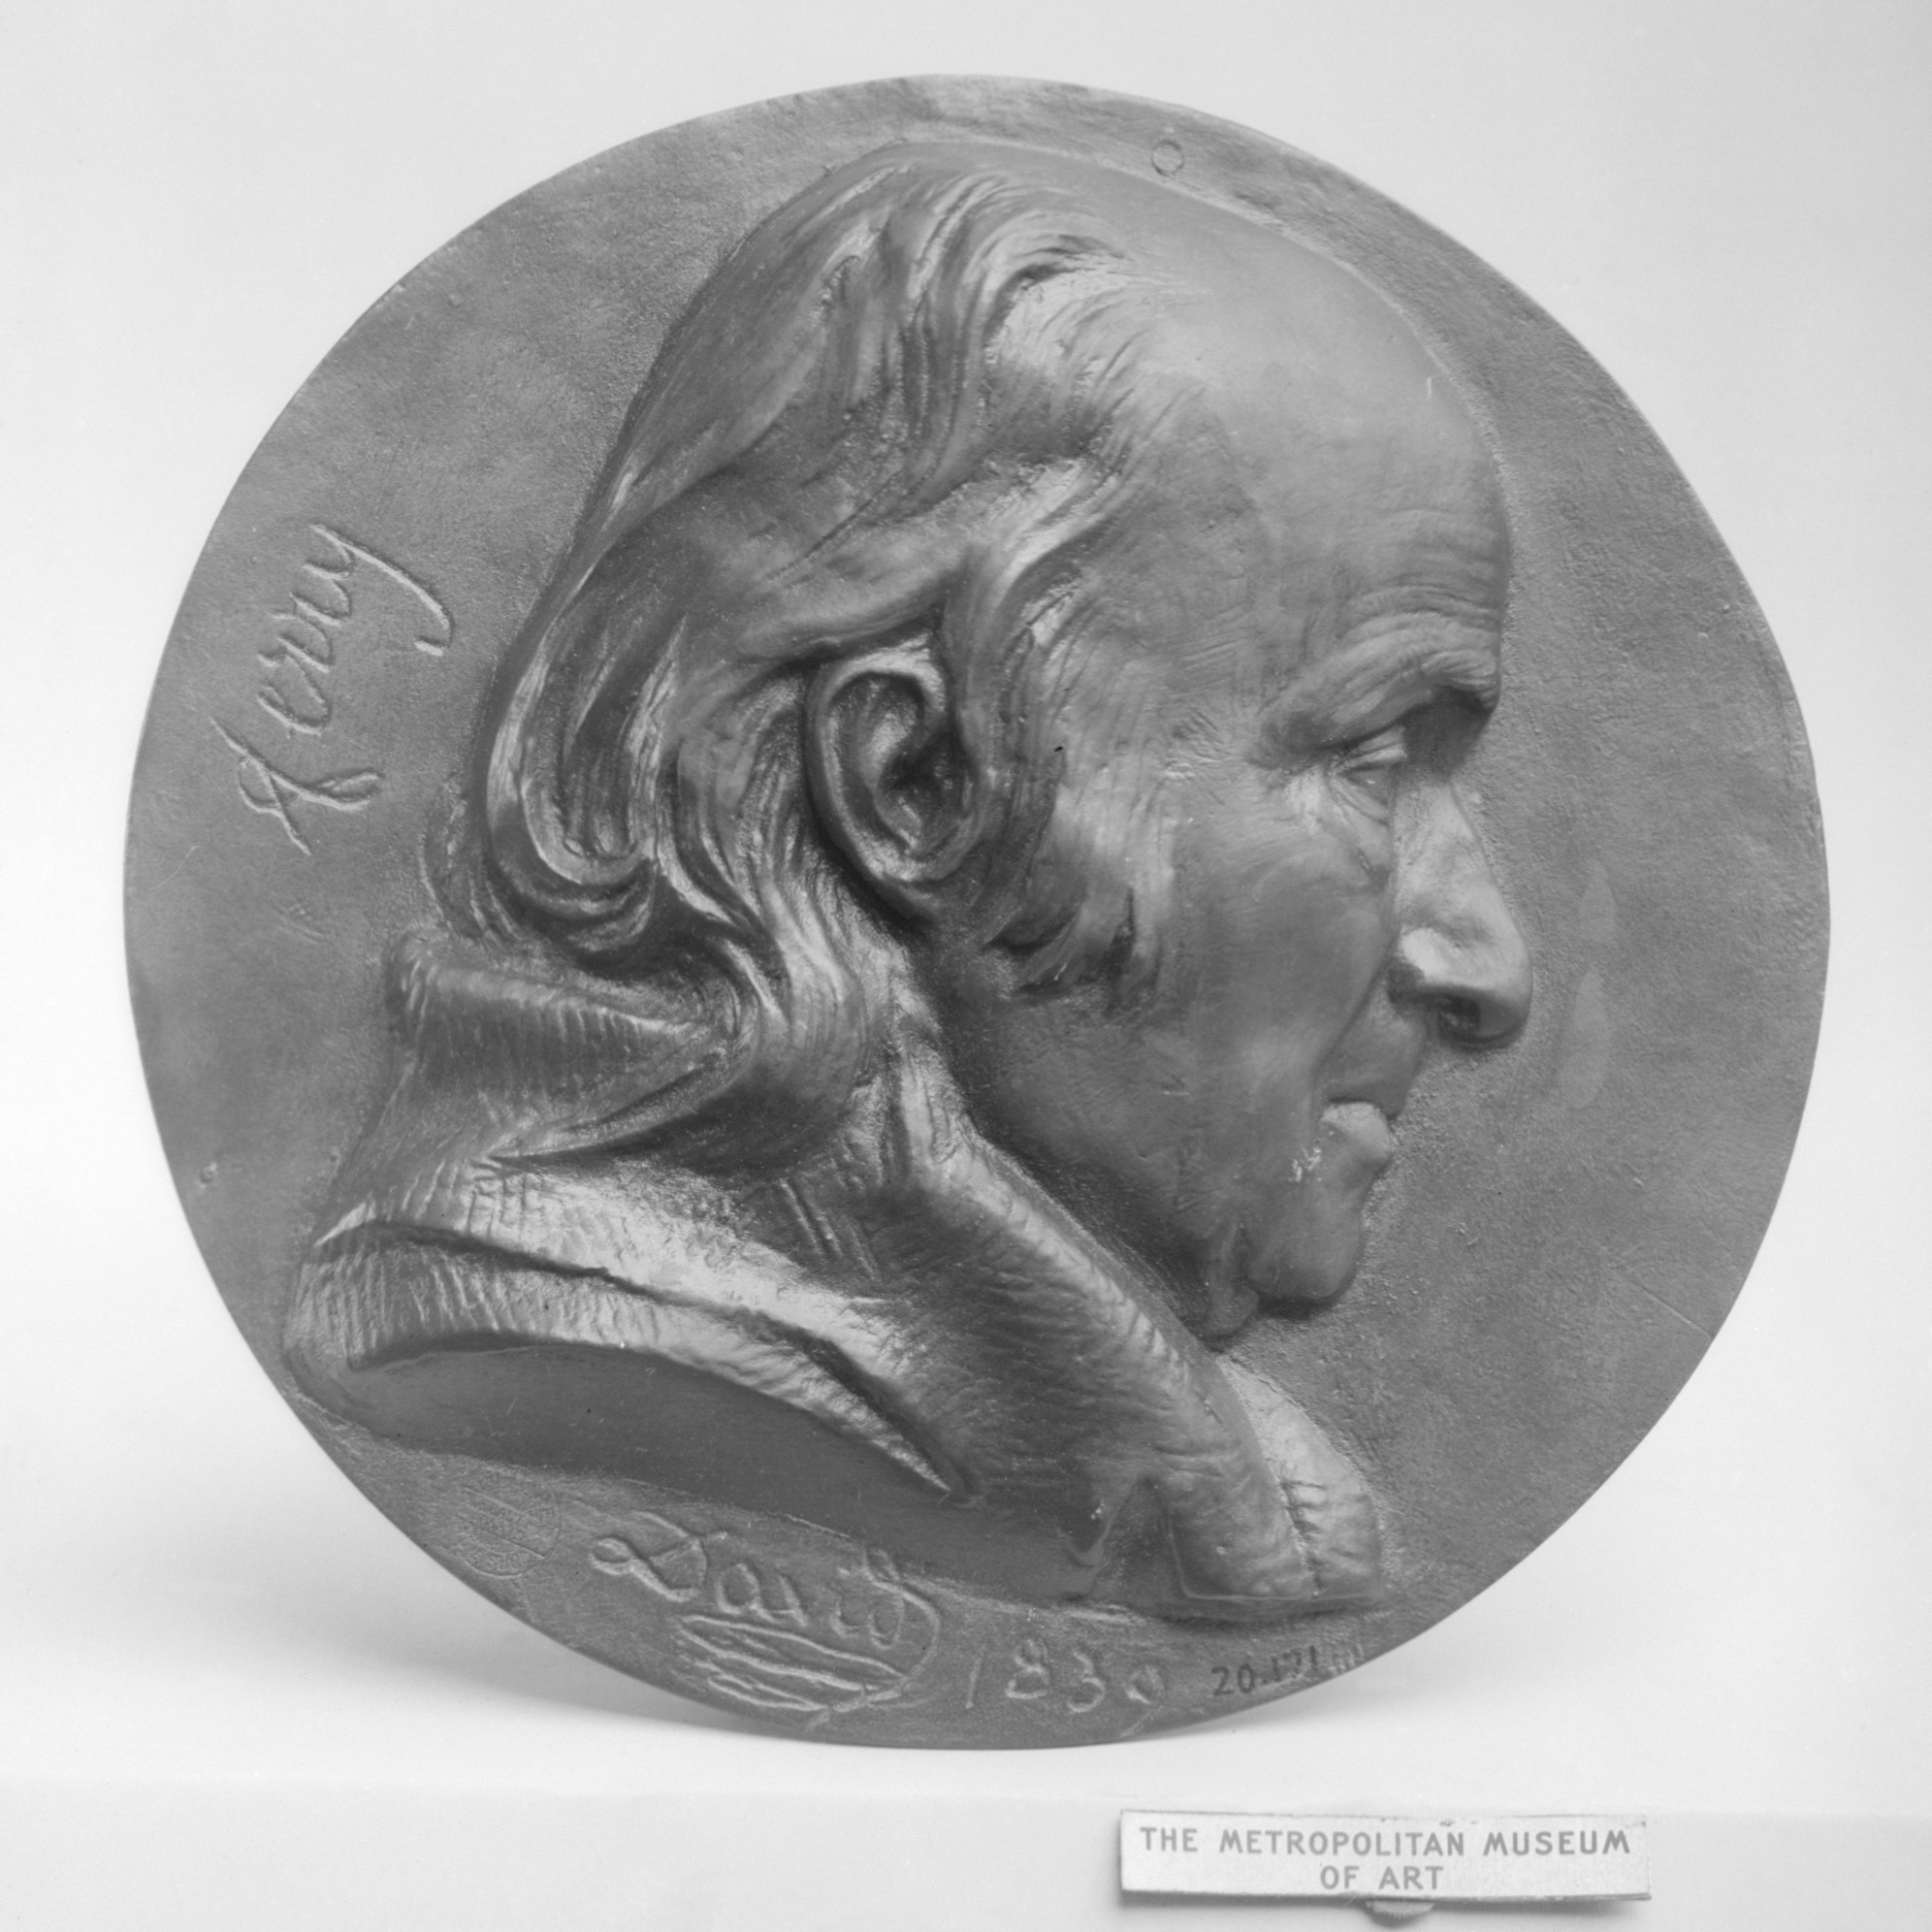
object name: medallion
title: Claude-Joseph Ferry (1756–1845), French savant and statesman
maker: pierre jean david d'angers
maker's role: artist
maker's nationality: french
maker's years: 1788-1856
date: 1839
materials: bronze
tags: men,profiles